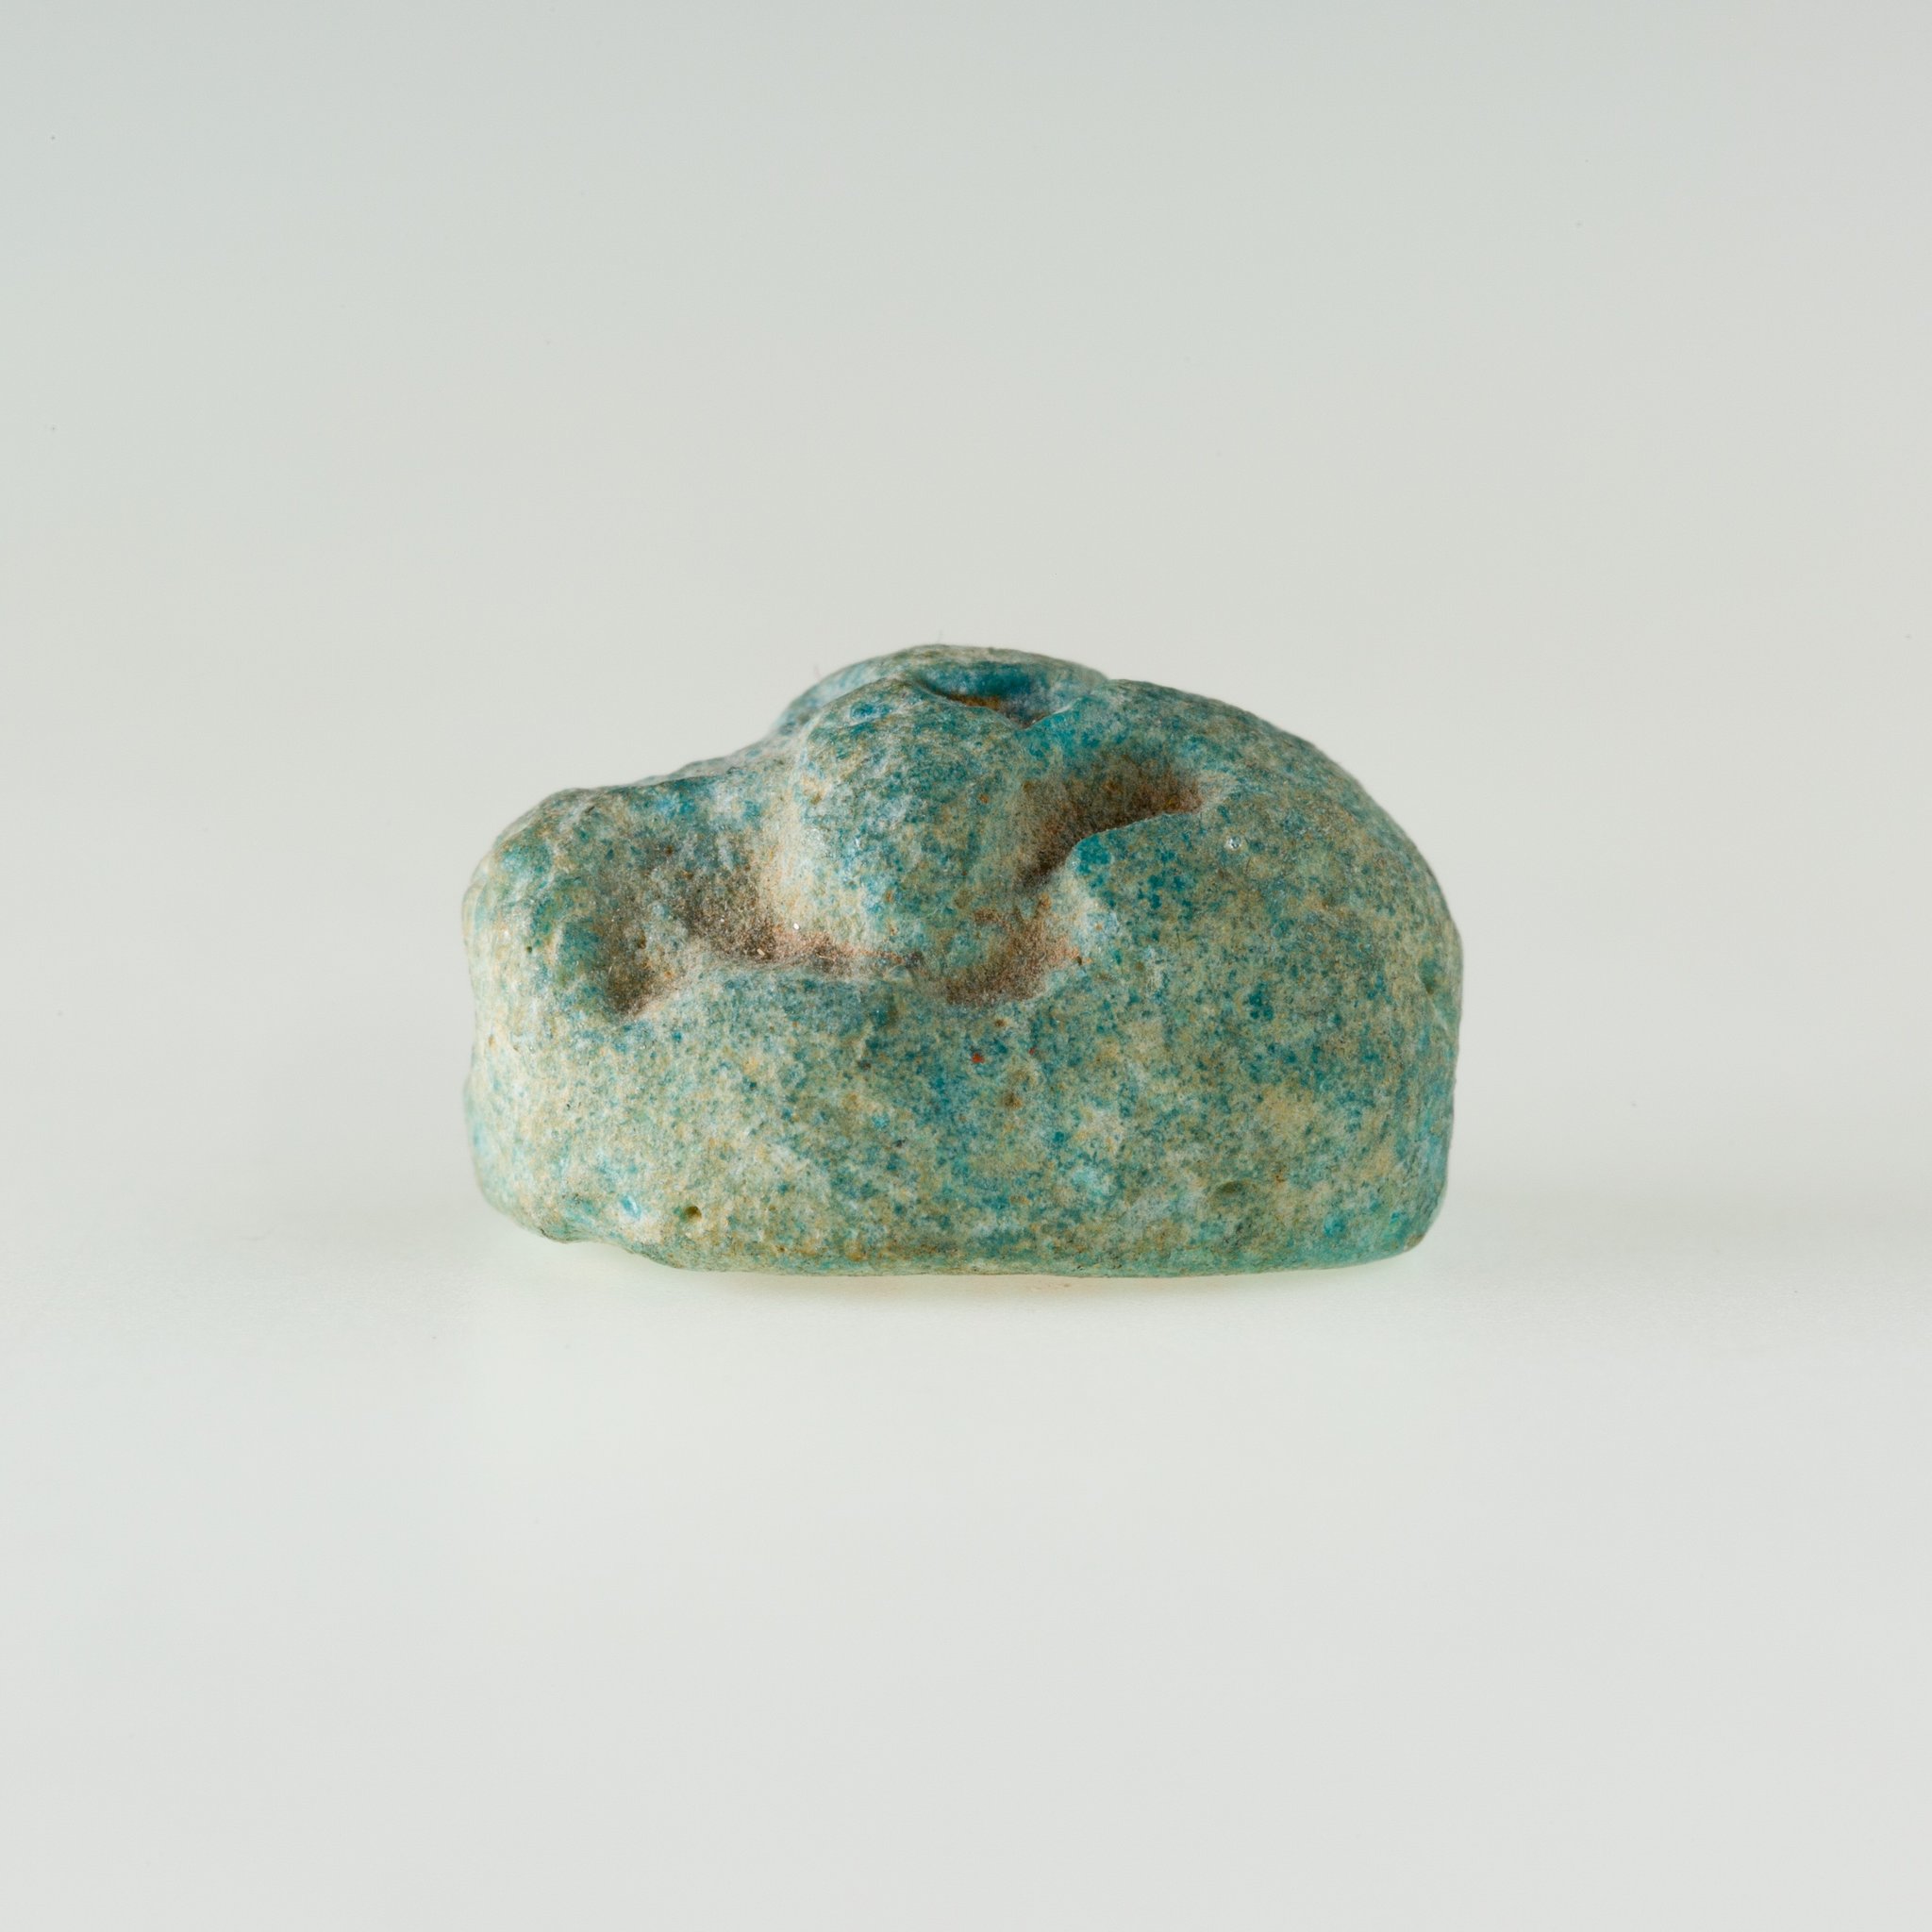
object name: animal amulet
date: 1981-1550 BCE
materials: faience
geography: egypt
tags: animals